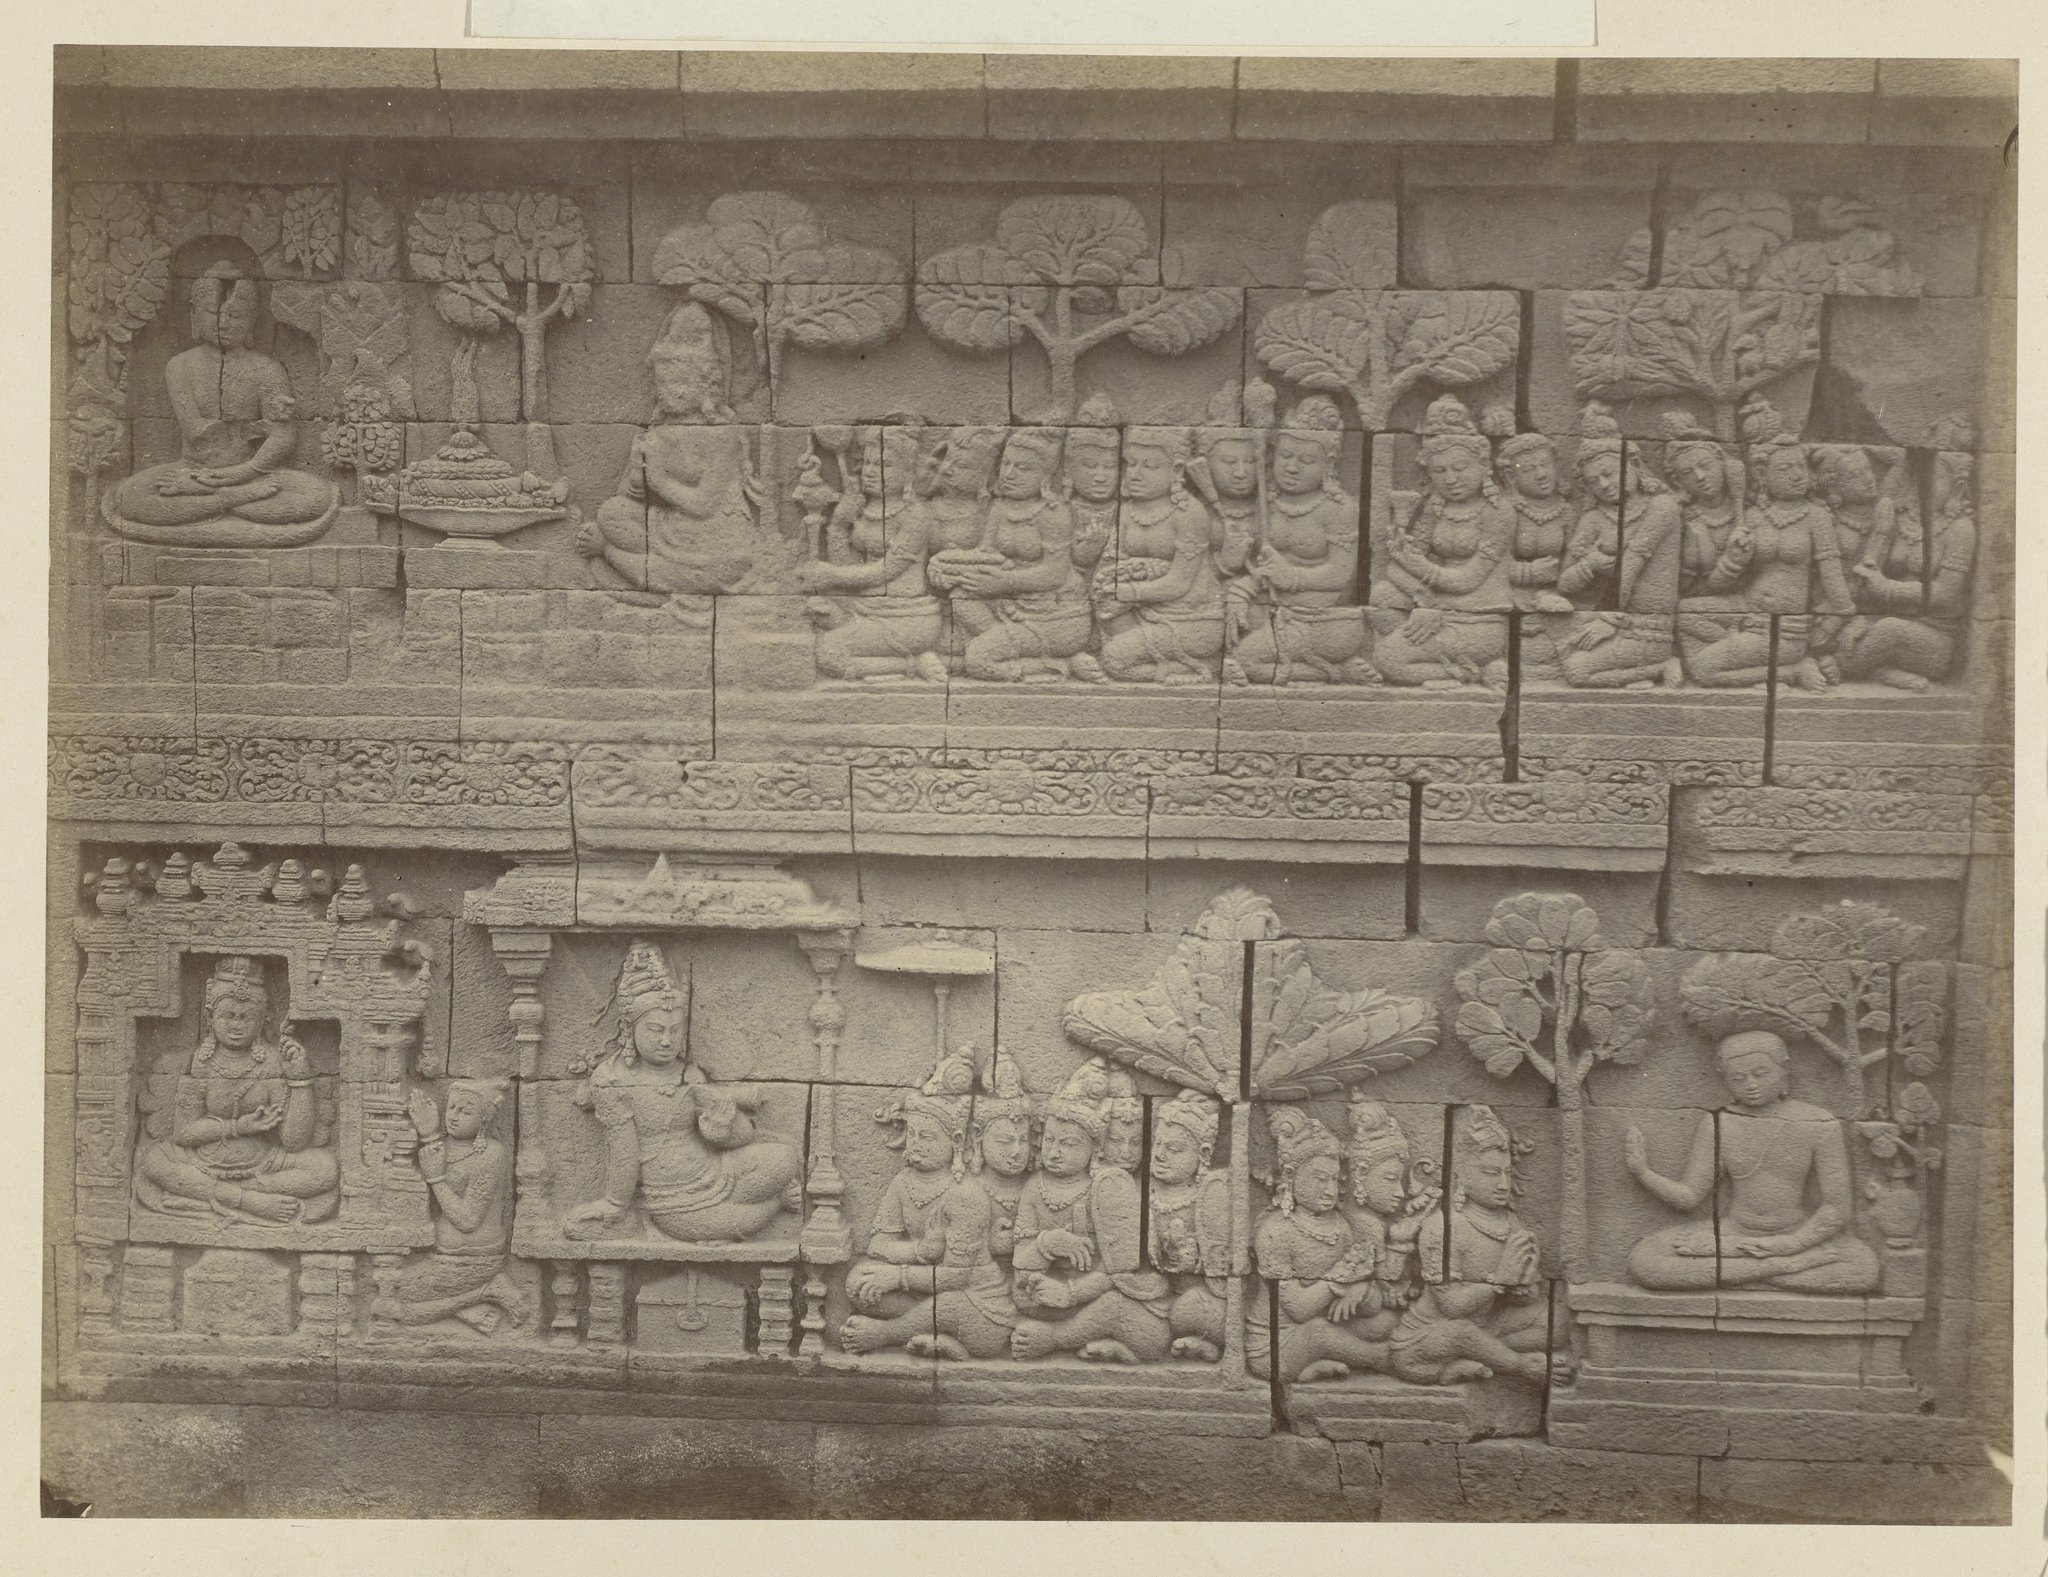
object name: photograph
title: Idem 2e gaanderij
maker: isidore kinsbergen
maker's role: fotograaf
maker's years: 1821-1905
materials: cardboard, paper, photographic support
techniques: albumen print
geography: java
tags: borobudur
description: Gallery I, main wall, north side 41 (top): relief 1a-78, Lalitavistara relief, the deceased mother of Siddhartha, in form of the goddess Mahadevi, visitis him while he is fasting and meditatiing. 42 (bottom) relief 1b 78, Avadana relief, Rudrayana story, Rudrayana learns about the misconduct of his son, the new king Cikhandin; king Cikhandin plns his assasination.. Borobudur village, Magelang district, Central Java province, 778-824 AD.